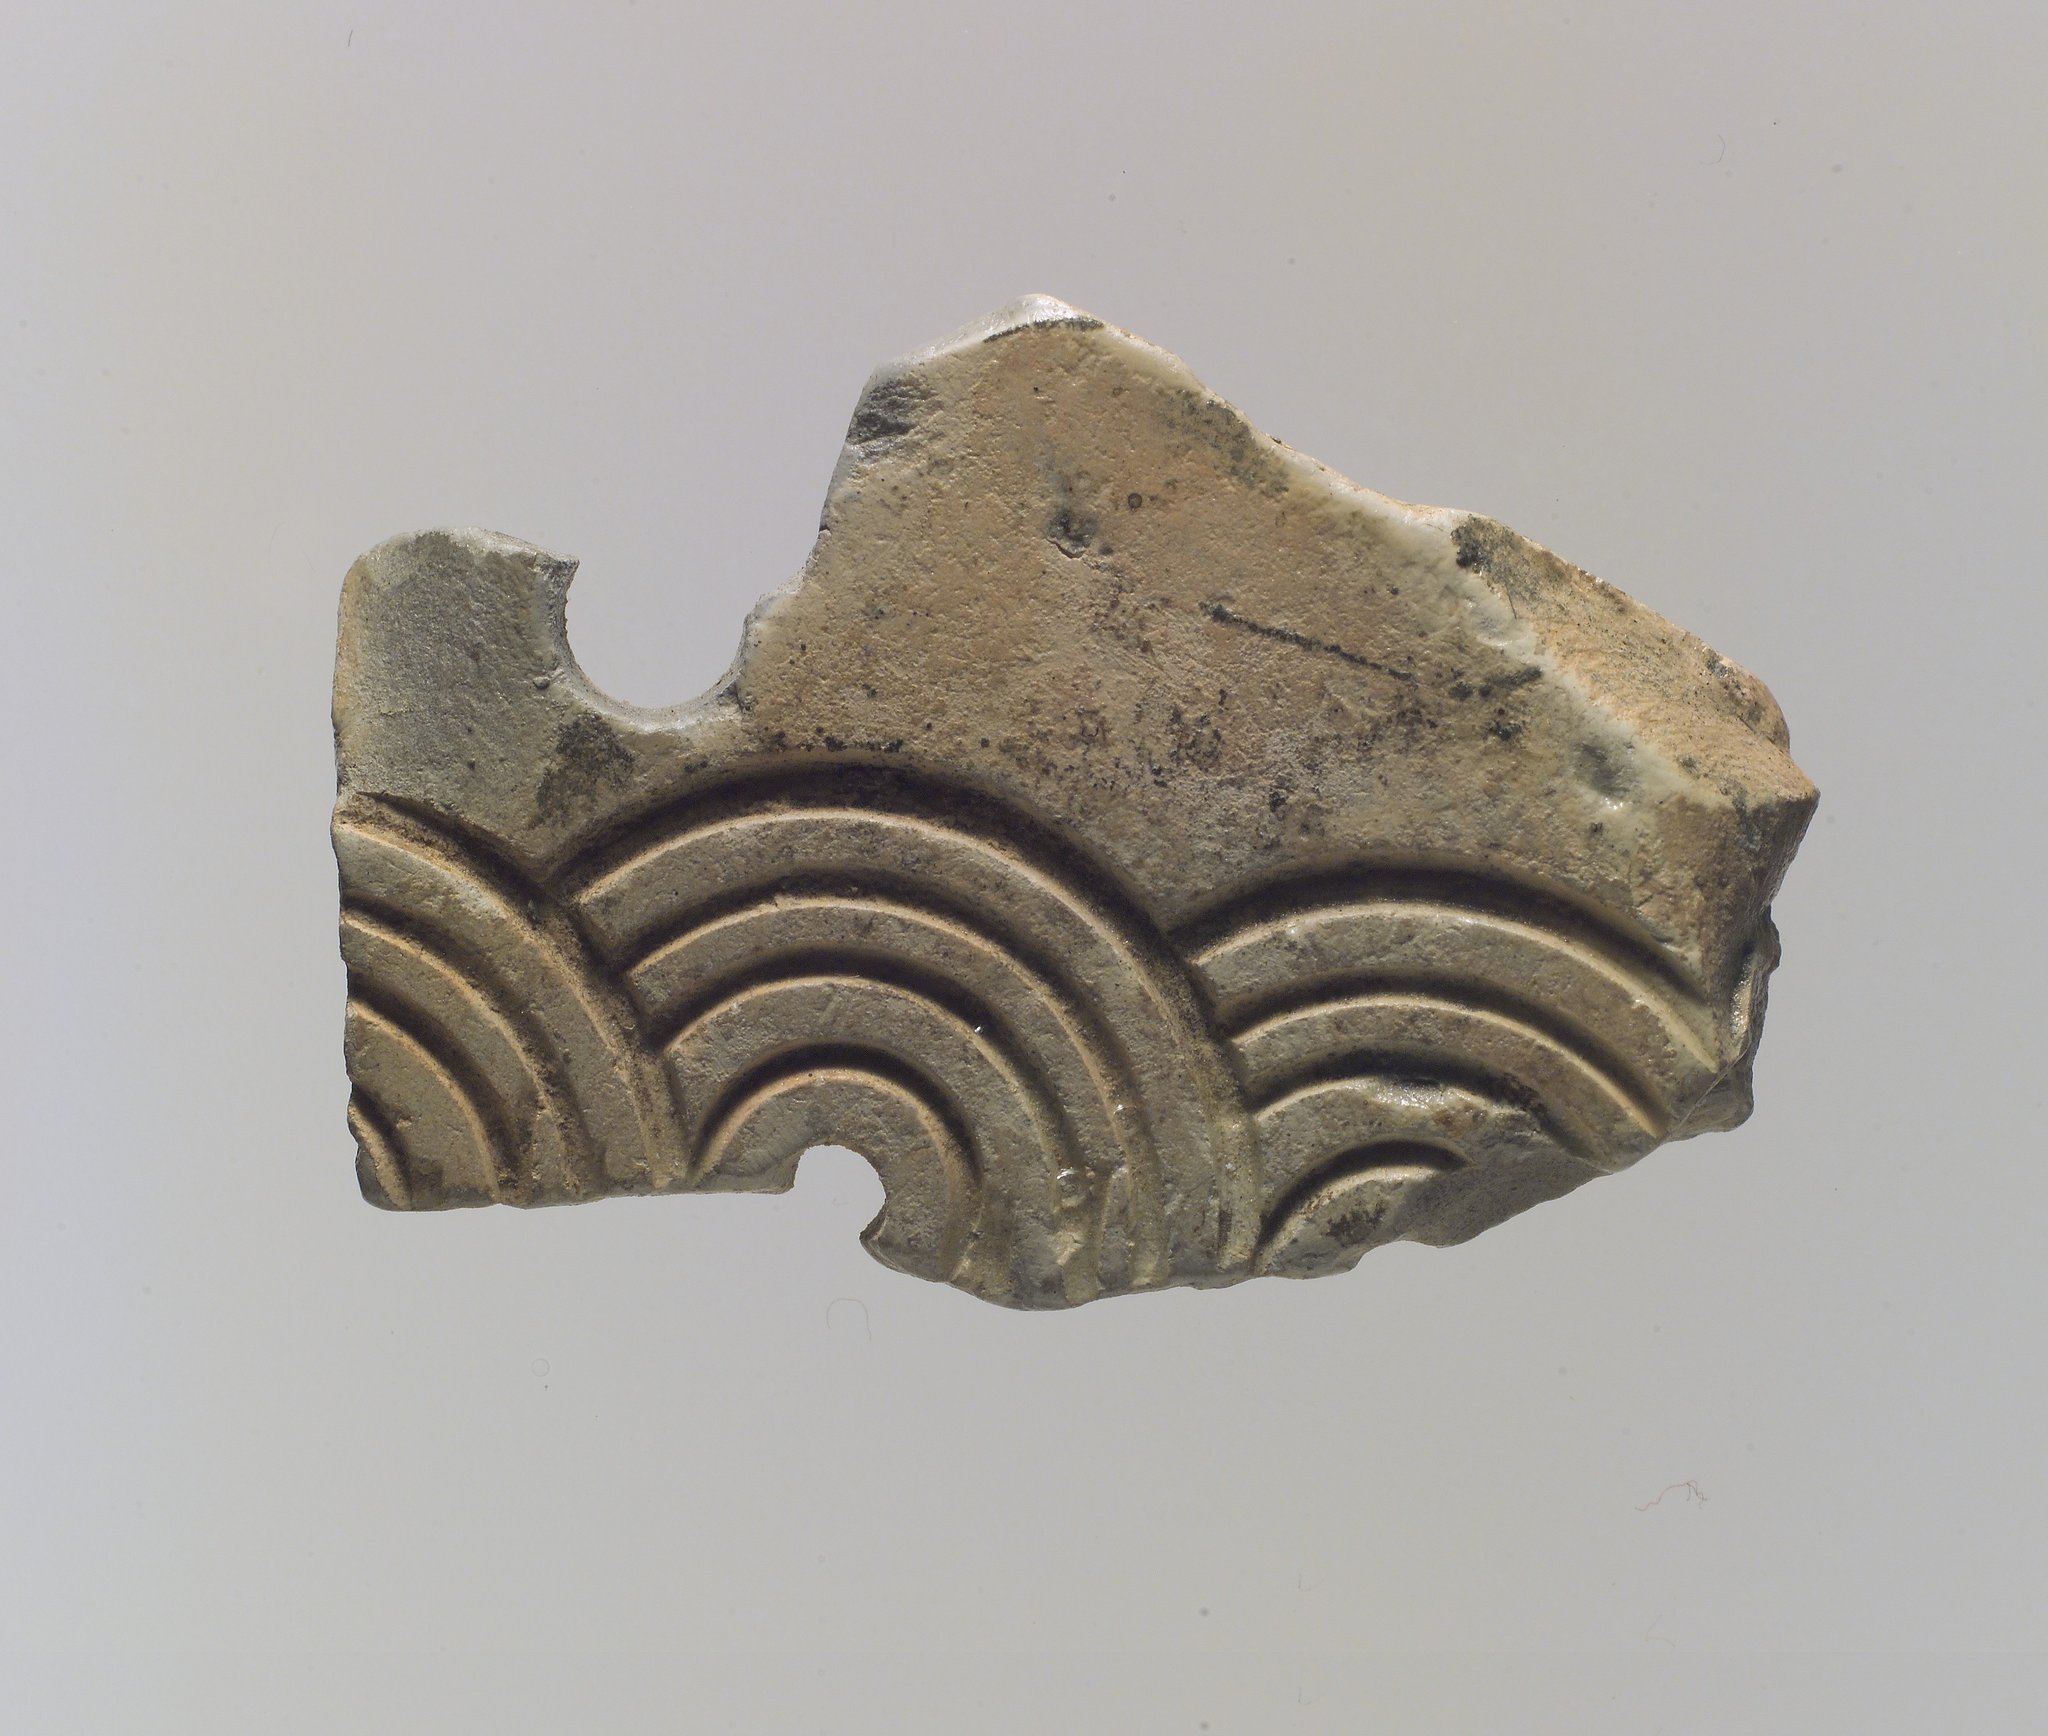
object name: relief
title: Plaque fragment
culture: assyrian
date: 1800-1701 BCE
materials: ivory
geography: anatolia